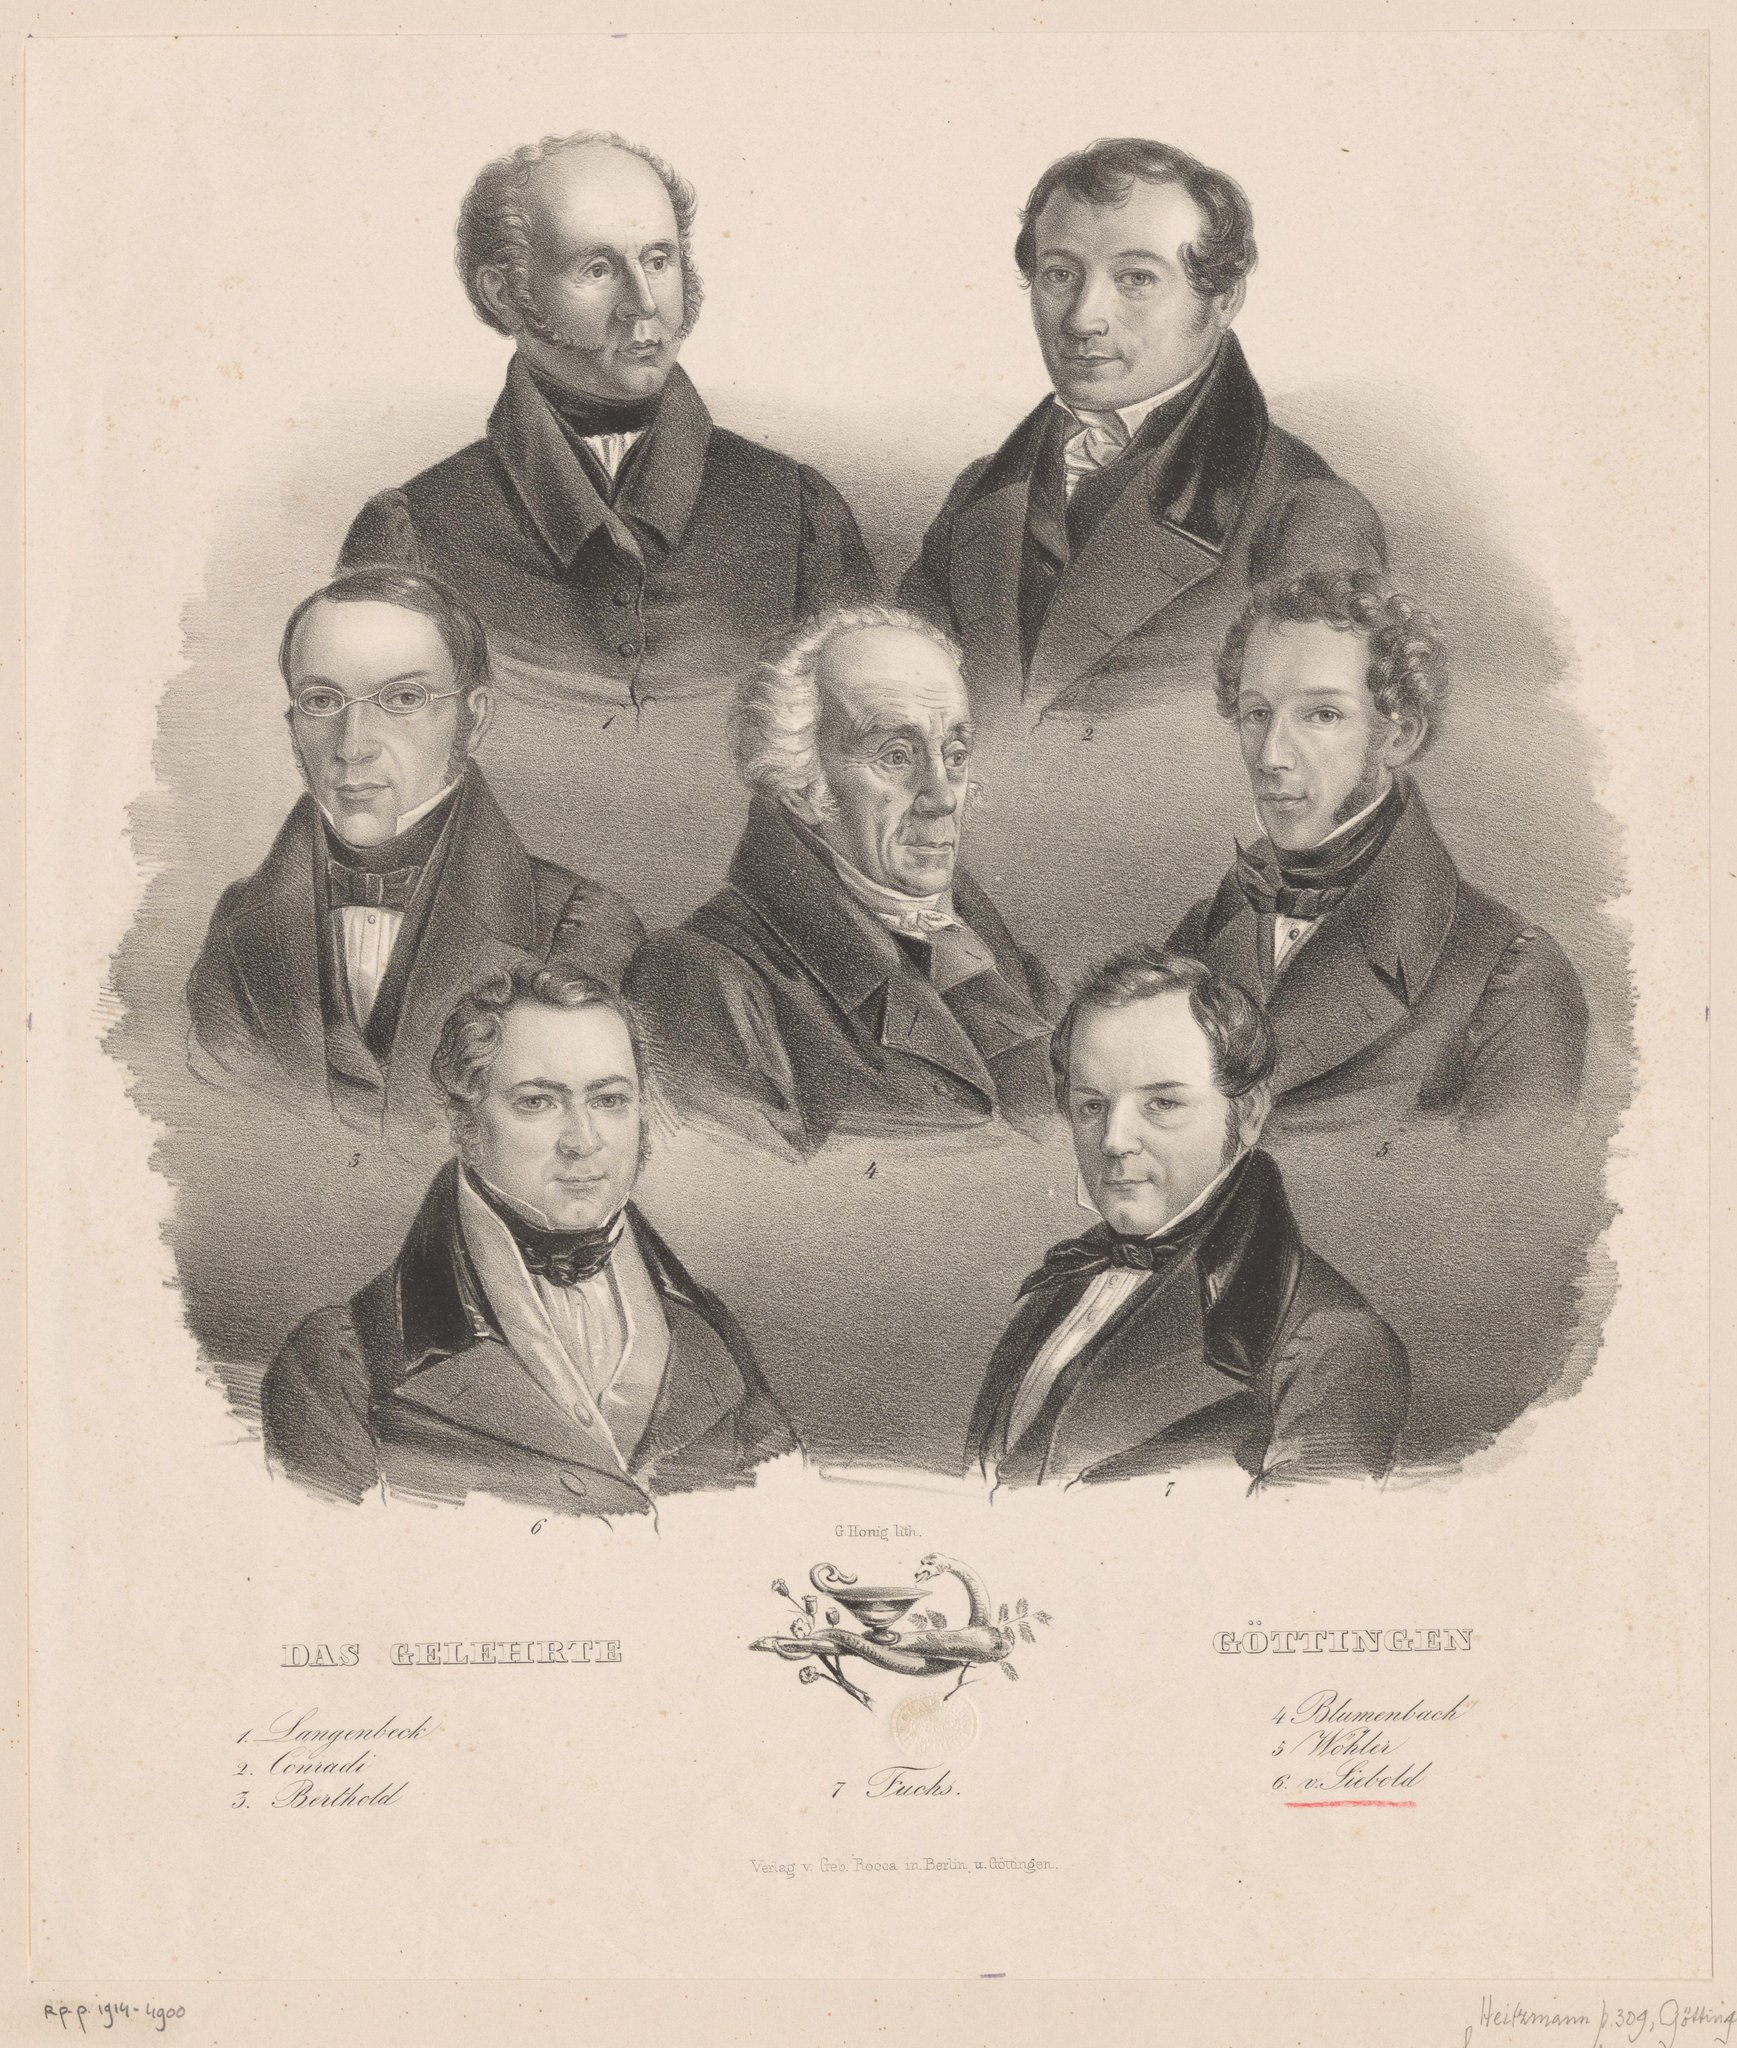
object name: print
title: Das Gelehrte Göttingen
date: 1830-1850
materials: paper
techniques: lithograph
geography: gottingen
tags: physicist, adult man, group of scholars or philosophers, historical persons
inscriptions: check stamp: ‘Gebrueder Rocca in Göttingen’, collector's mark: Lugt 2228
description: Portretten van: Conrad Johann Martin Langenbeck, Johann Wilhelm Heinrich Conradi, Arnold Adolph Berthold, Johann Friedrich Blumenbach, Friedrich Wöhler, Eduard Caspar Jacob von Siebold en Conrad Heinrich Fuchs.